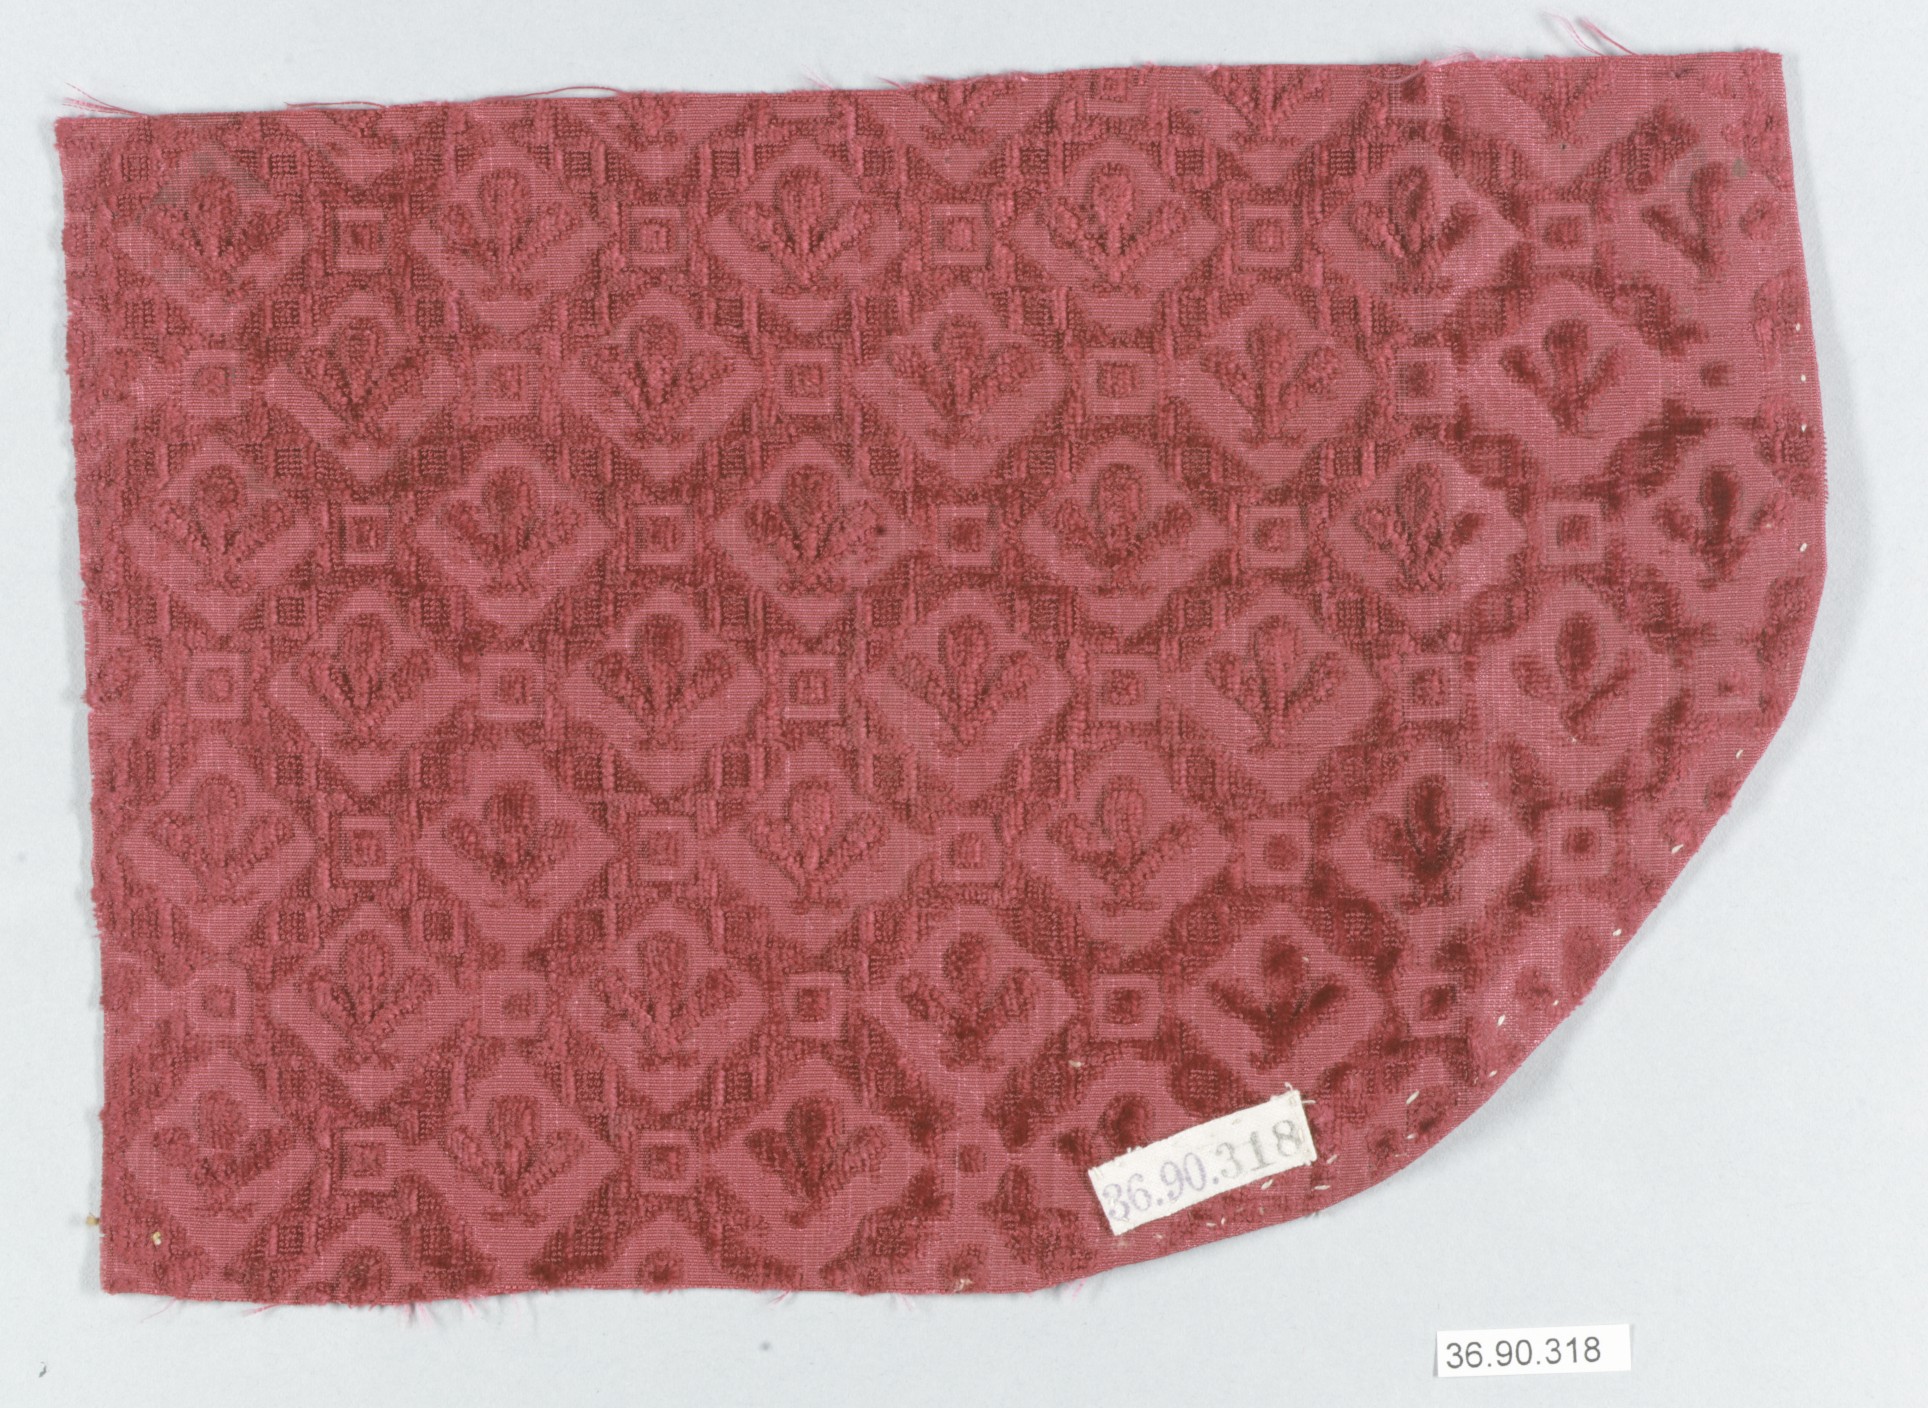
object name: piece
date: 1501-1700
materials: silk